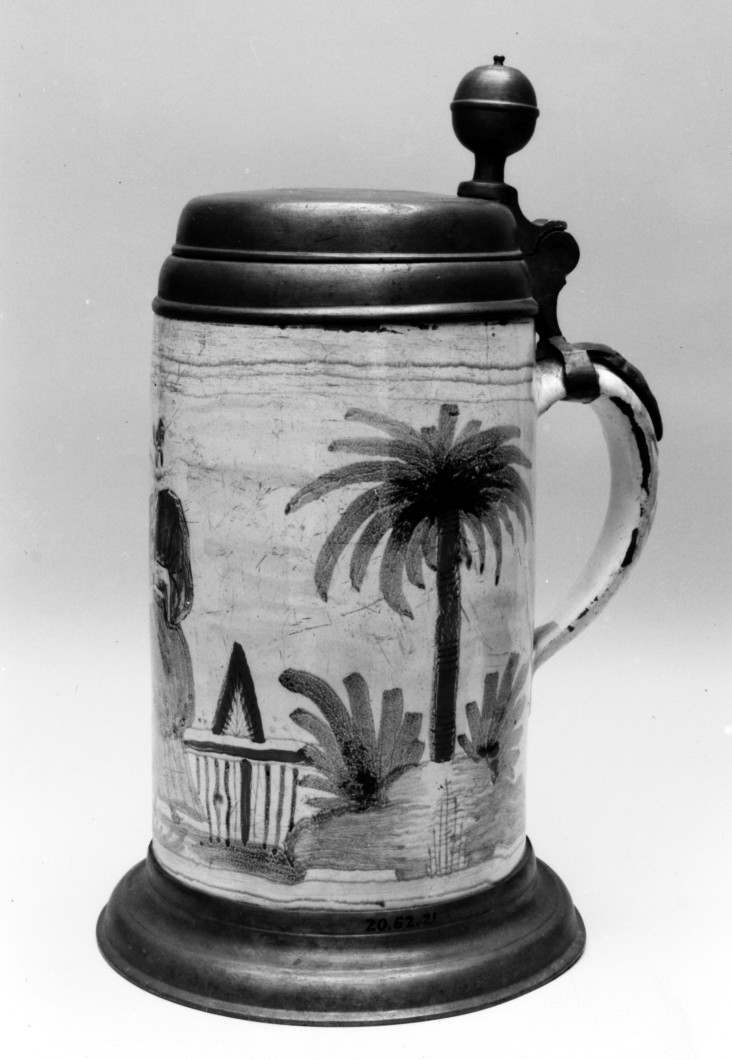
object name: tankard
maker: johann gottlieb menicus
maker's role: maker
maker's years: 1733-1756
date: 1701-1800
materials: earthenware, pewter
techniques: glazing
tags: trees